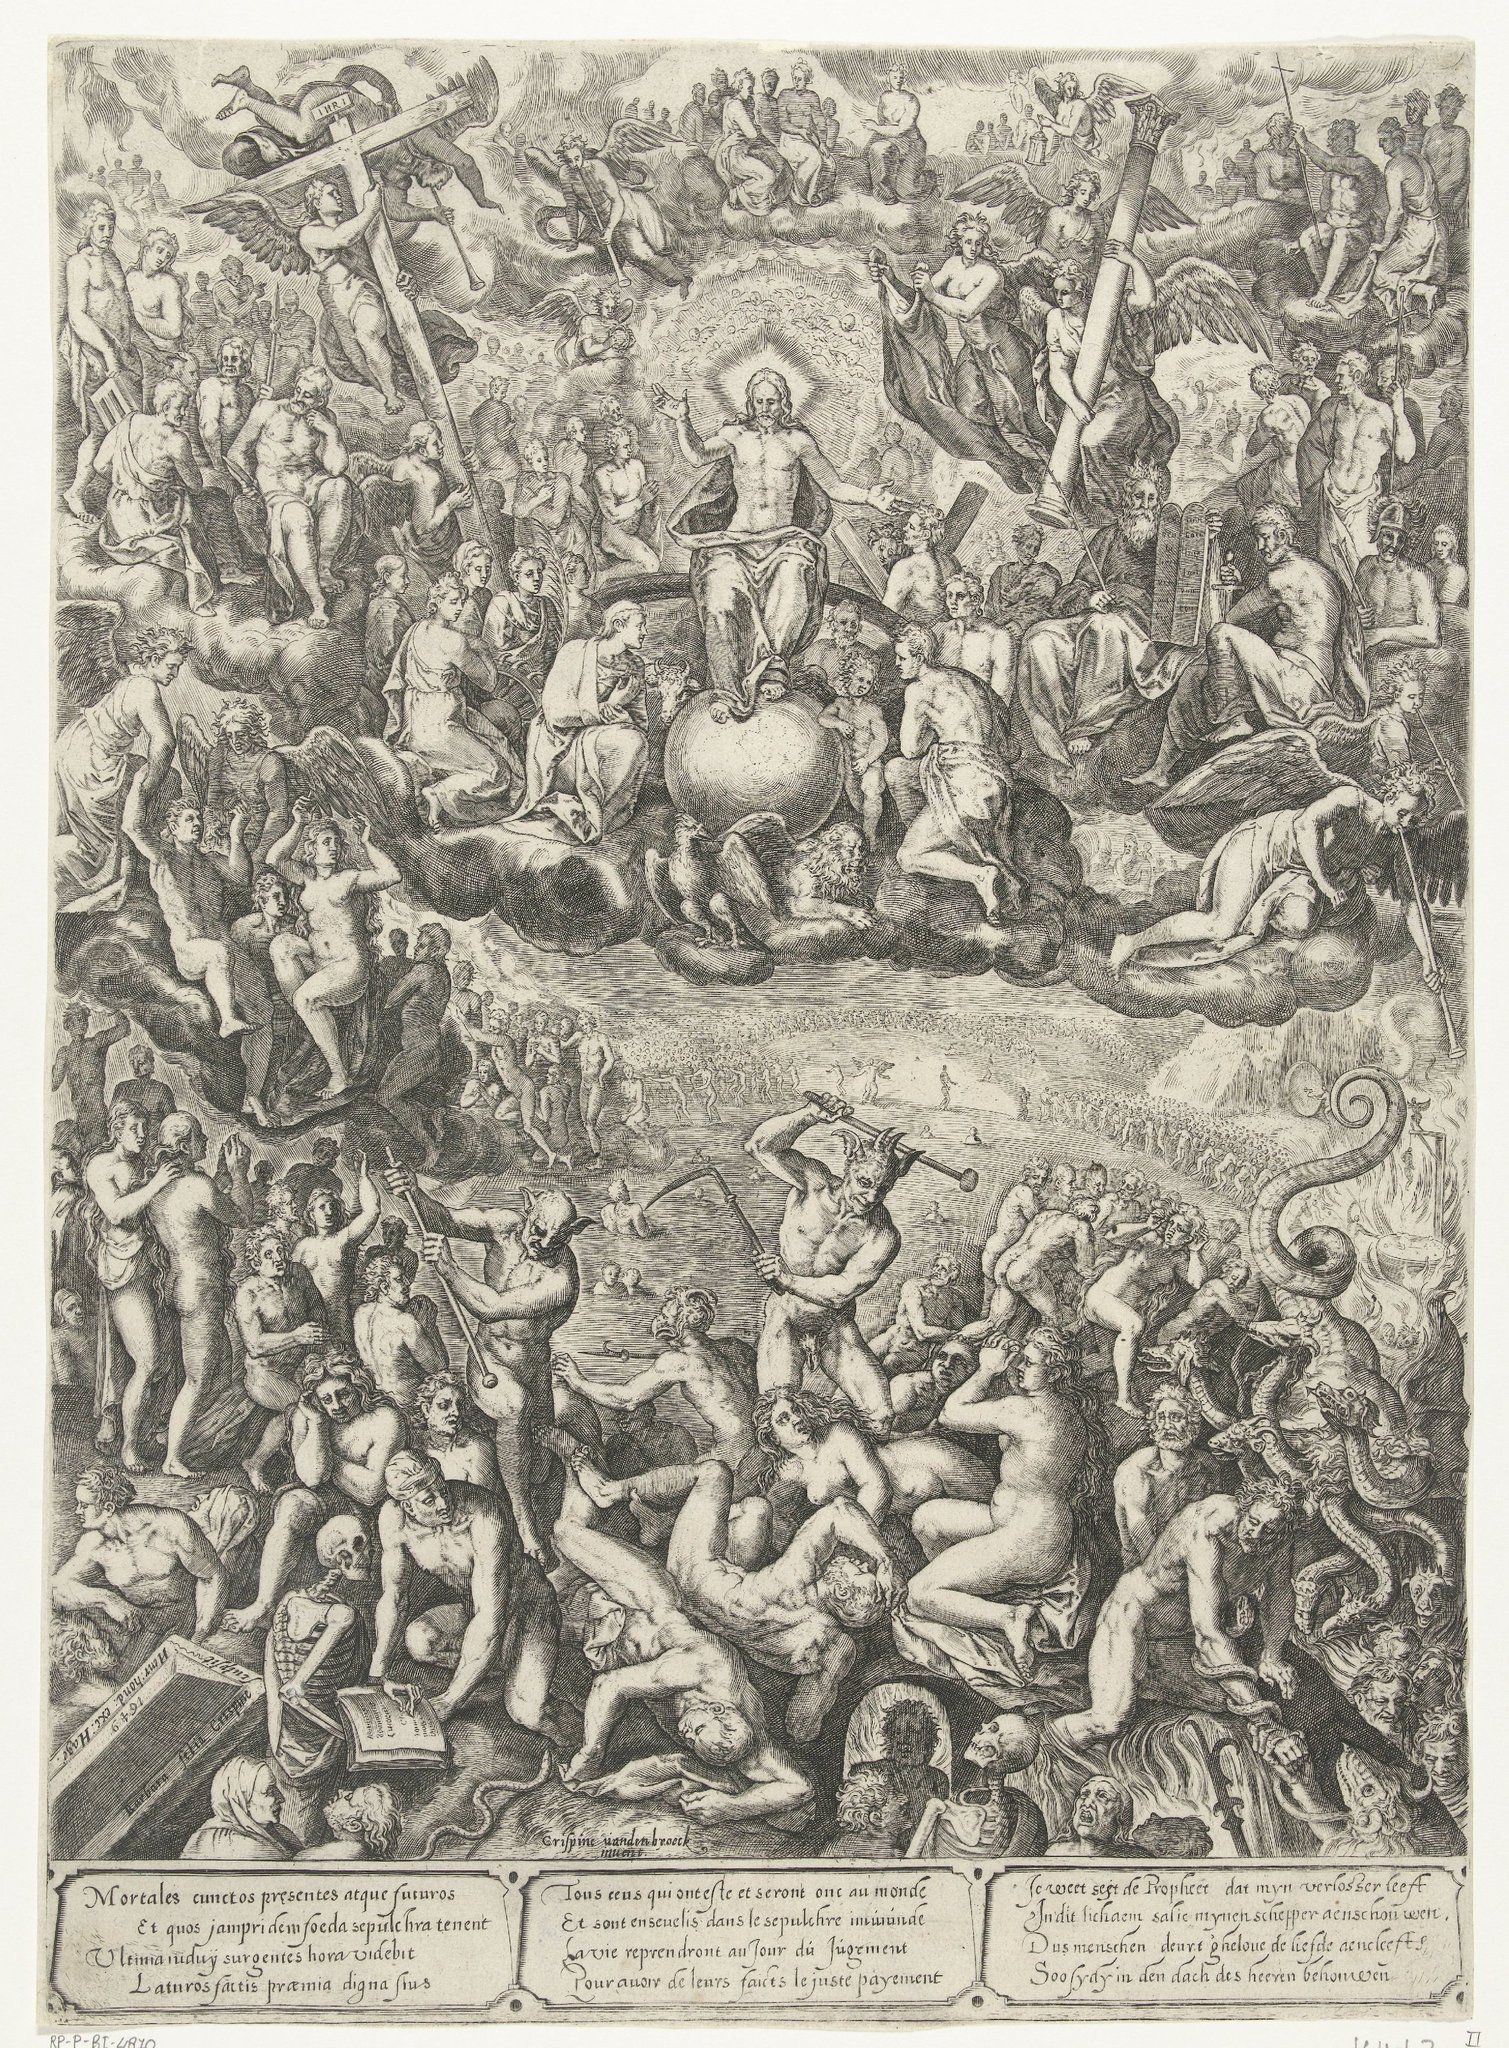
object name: print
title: The Last Judgement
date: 1649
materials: paper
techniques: engraving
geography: the hague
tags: comprehensive representation of last judgement: christ (with sword and lily), often surrounded by elders and sometimes accompanied by mary and john the baptist, appears in the sky with trumpeting angels (and sometimes angels holding the instruments of the passion); after the resurrection of the dead the blessed are led to heaven by angels, and the damned are dragged into hell by devils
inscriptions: collector's mark: Lugt 2228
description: Barbara van den Broeck based this impressive depiction of The Last Judgement on a painting by her father. Depictions of this important Biblical subject were popular, and such monumental prints, which were often mounted on the wall much like paintings, served a devotional purpose. Aiming at a wide audience, the plate was provided with a quote from the Bible in three languages.